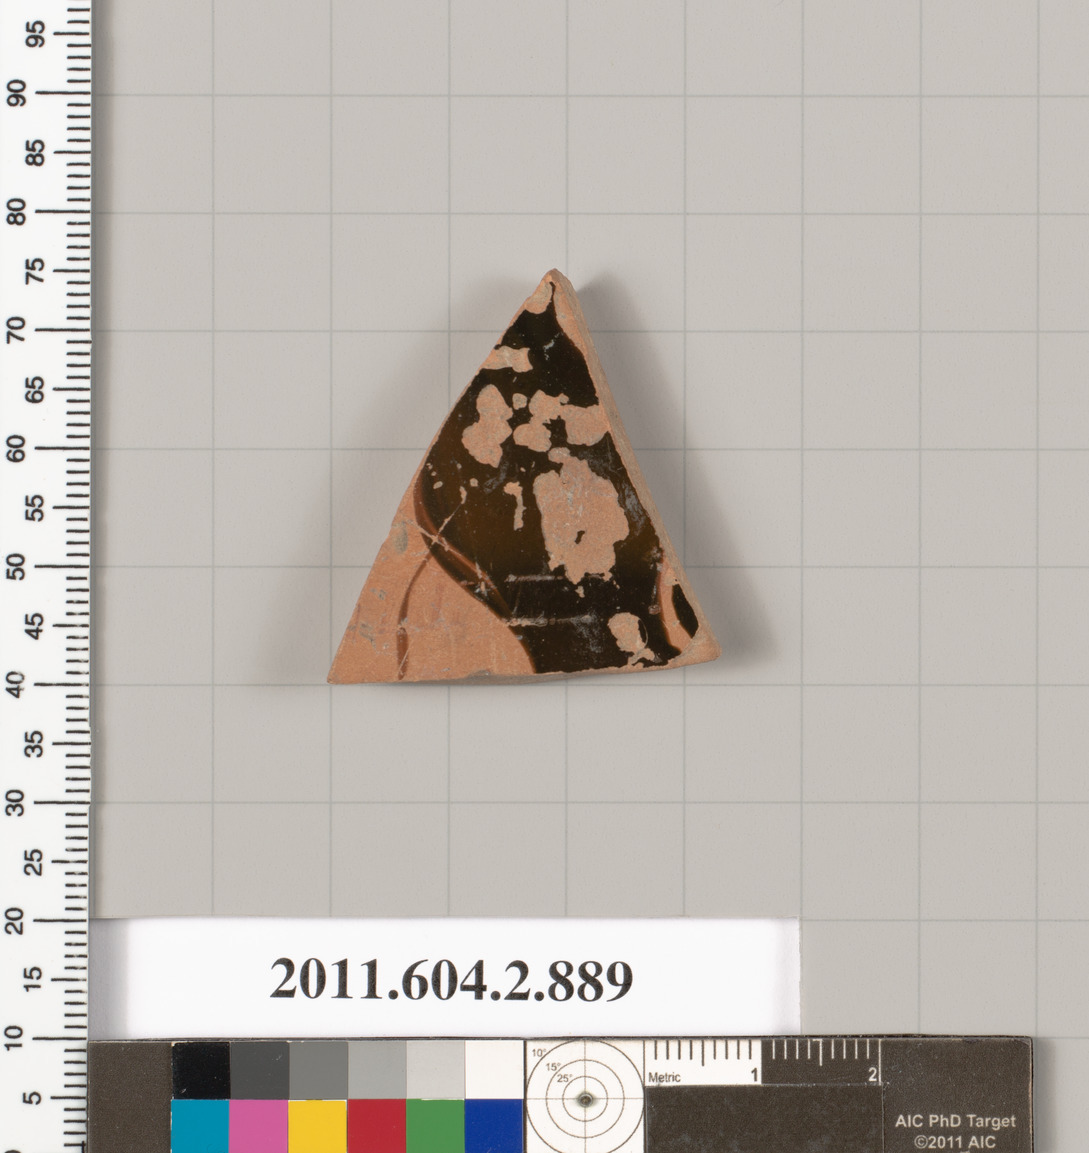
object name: bell krater fragment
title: Terracotta fragment of a bell-krater (bowl for mixing wine and water)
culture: greek, attic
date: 450-426 BCE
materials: terracotta